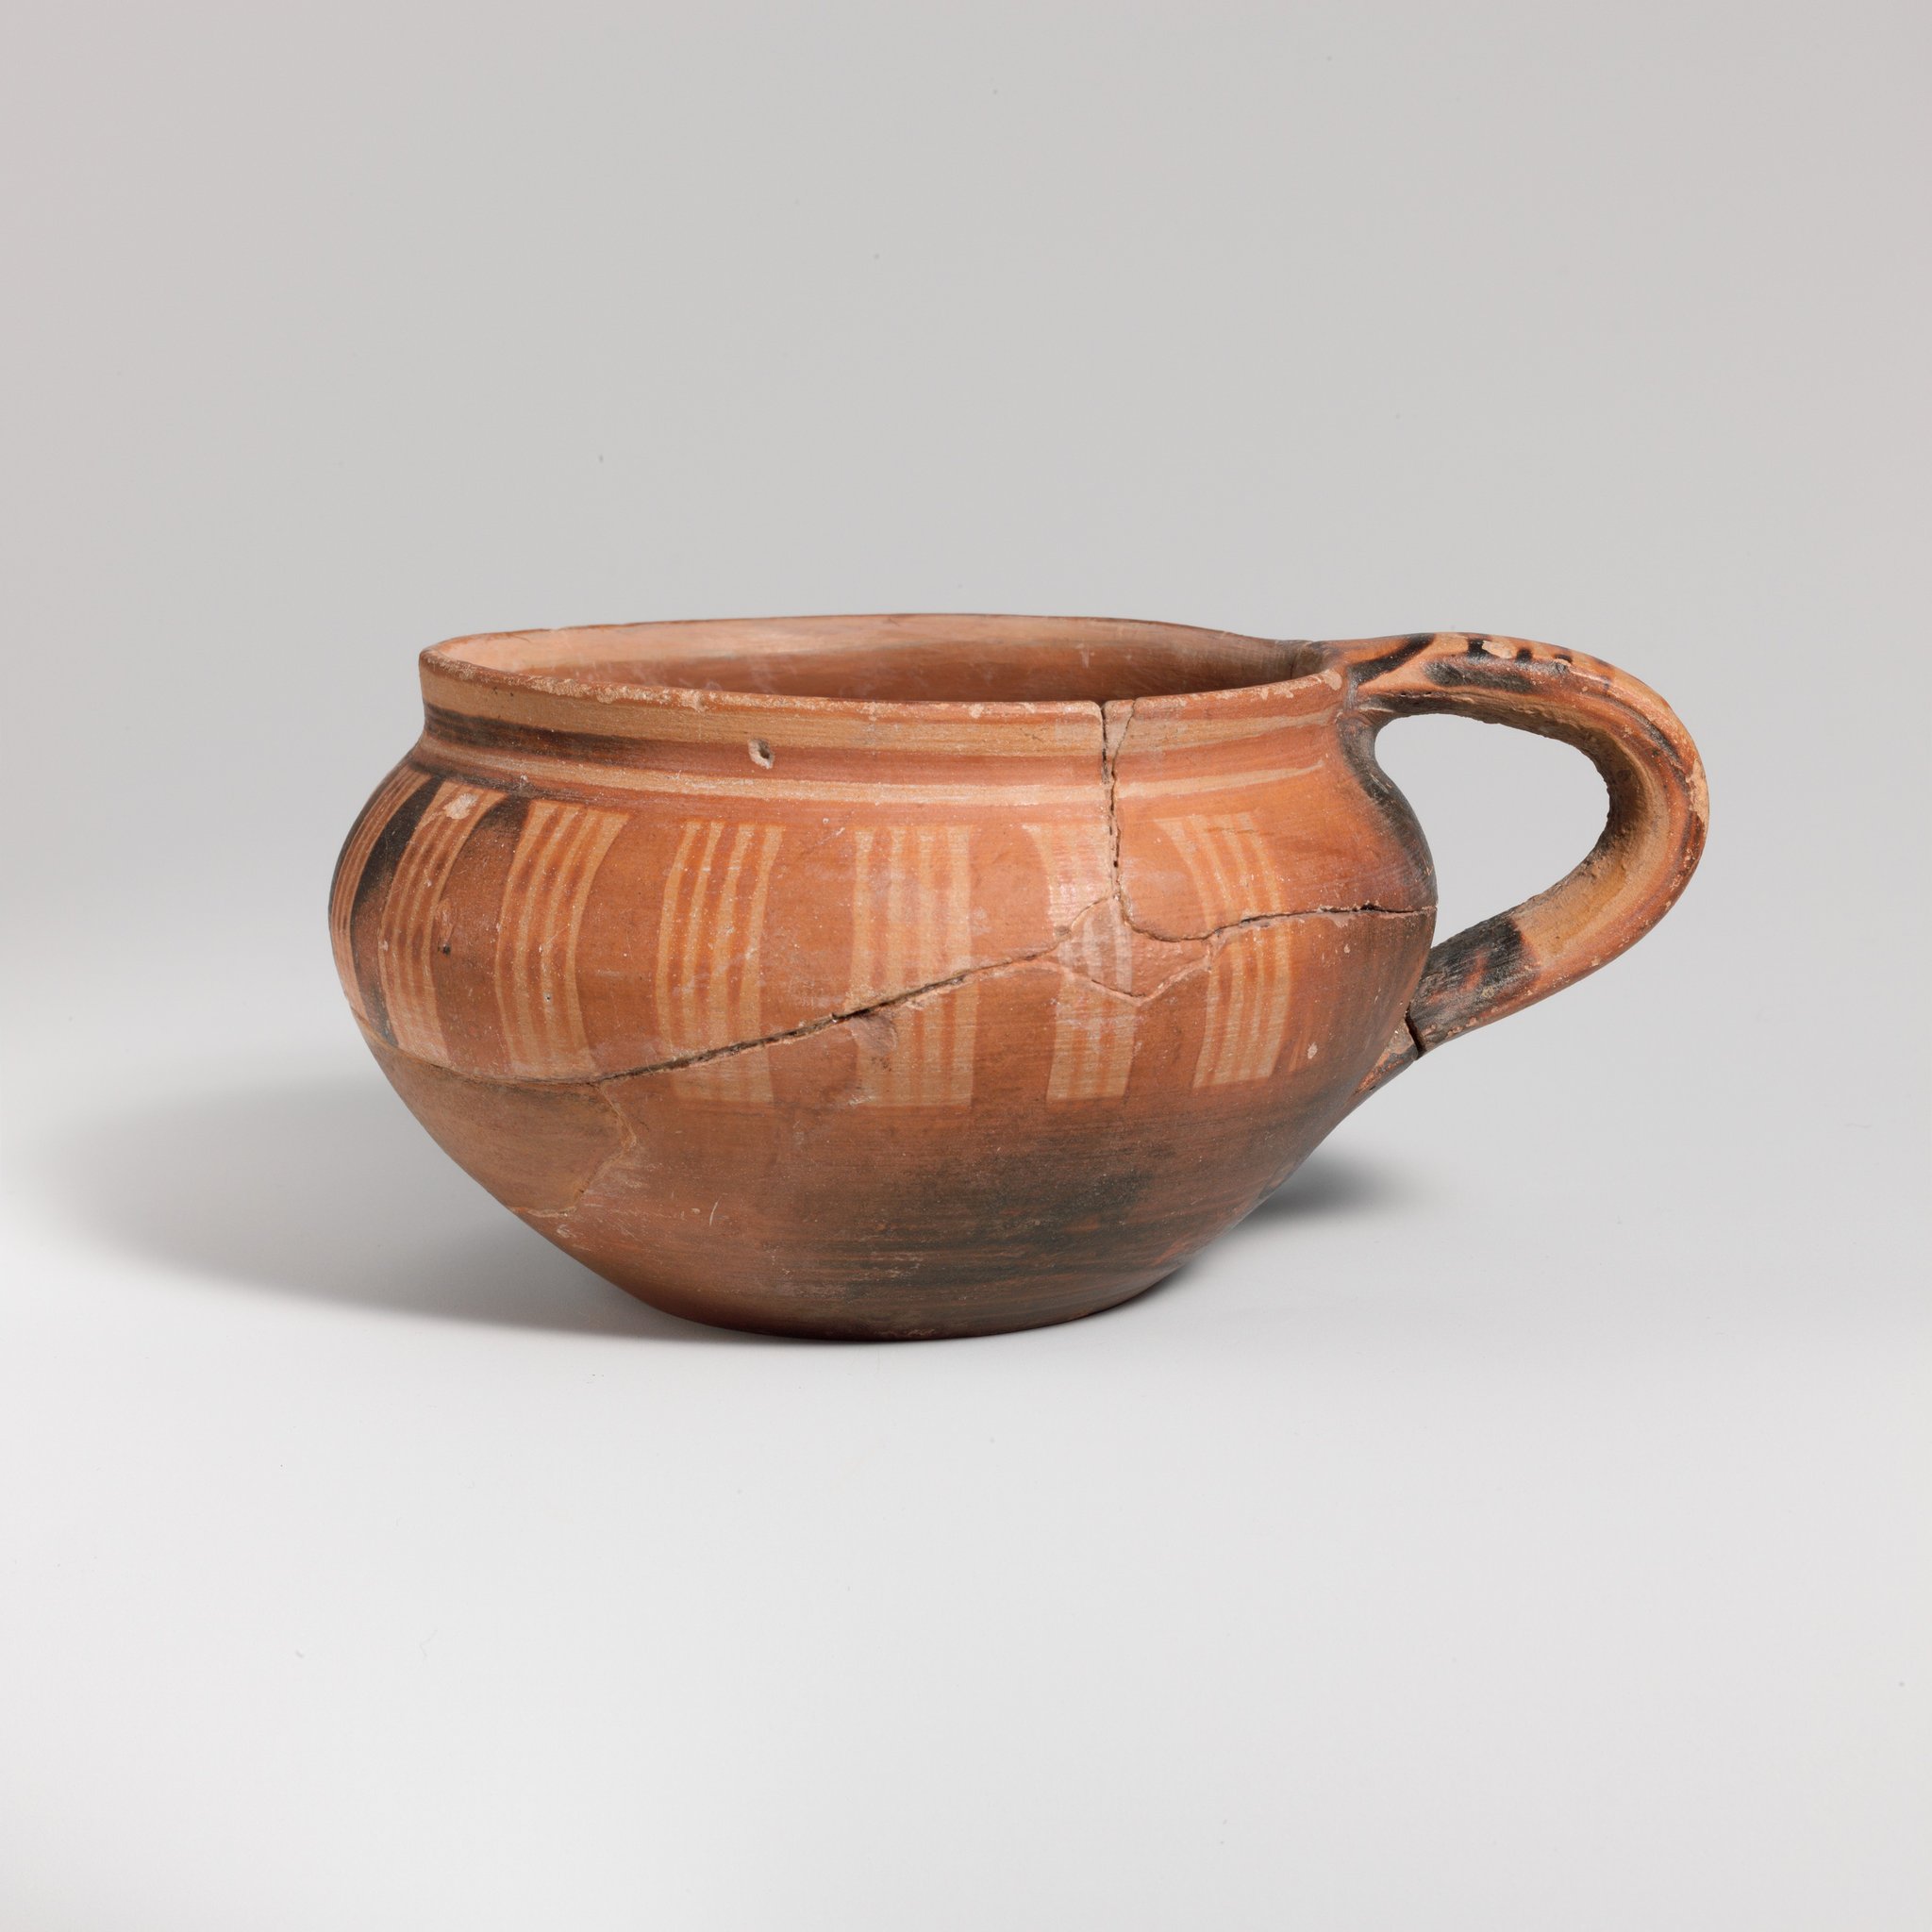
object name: cup, one handled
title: Terracotta one-handled cup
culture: greek, attic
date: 734-701 BCE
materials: terracotta